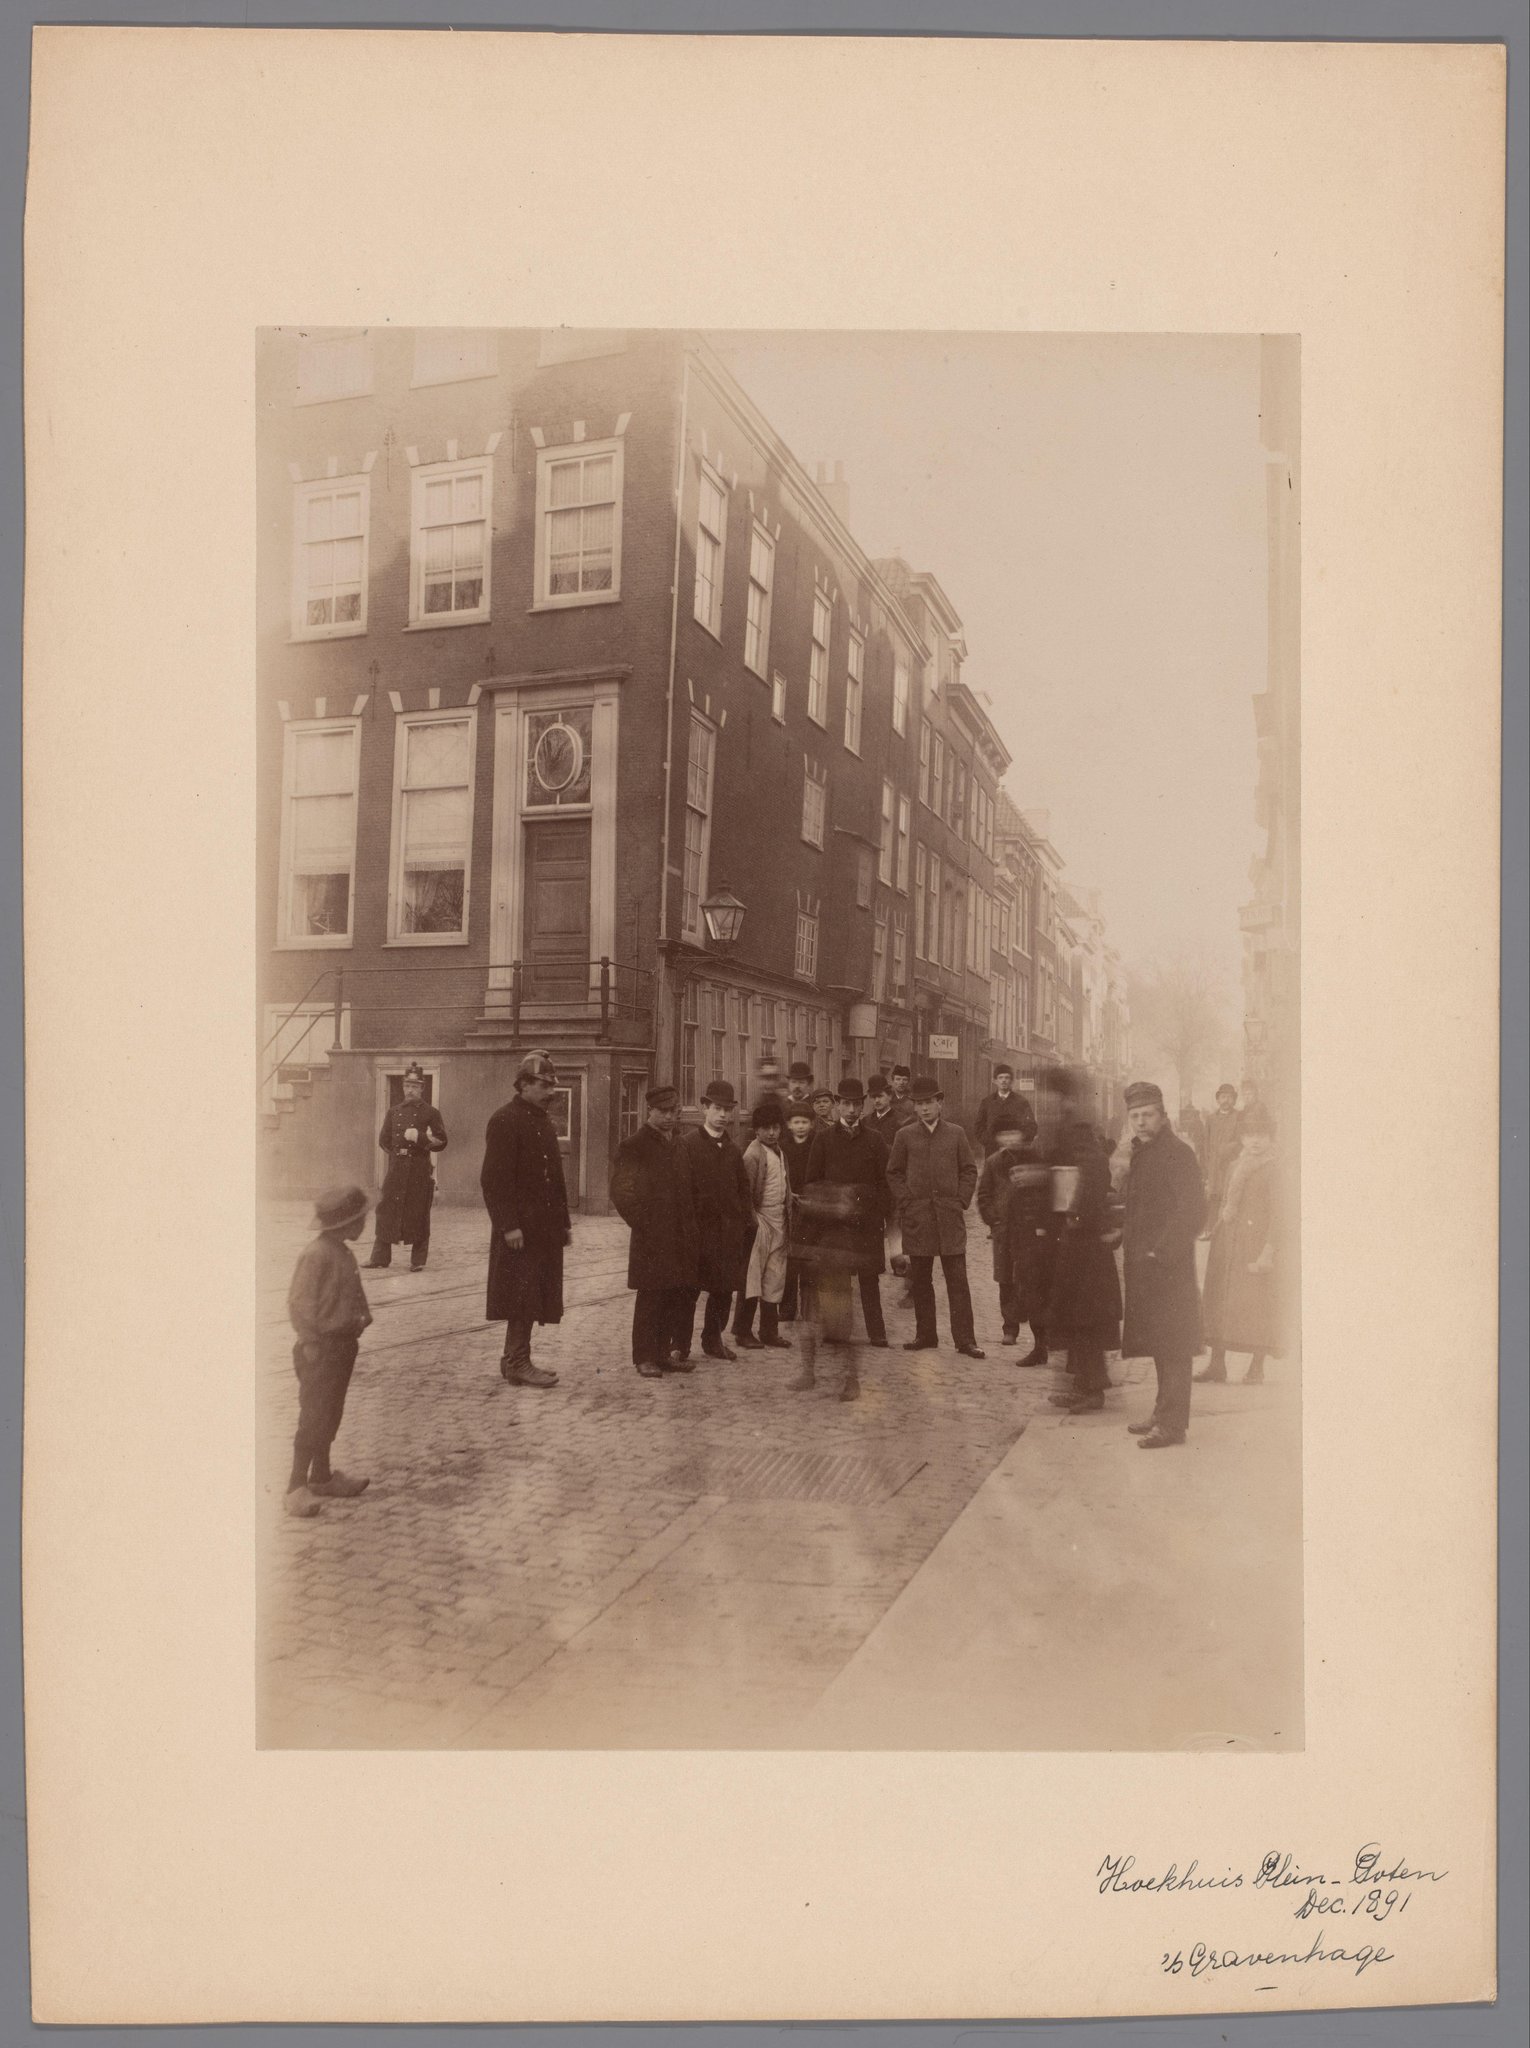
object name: photograph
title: Gezicht op het hoekhuis van Plein en Korte Poten te Den Haag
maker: anoniem (monumentenzorg)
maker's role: fotograaf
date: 1891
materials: cardboard, photographic support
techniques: albumen print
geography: plein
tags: urban housing, public road (+ city(-scape) with figures, staffage)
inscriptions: annotation: ‘'s Gravenhage/ Hoekhuis Plein-Pooten/ Dec 1891’, collector's mark: ‘R:MUS.’ Lugt 2228, annotation: ‘Hoekhuis Plein-Poten/ Dec. 1891/ 's Gravenhage’